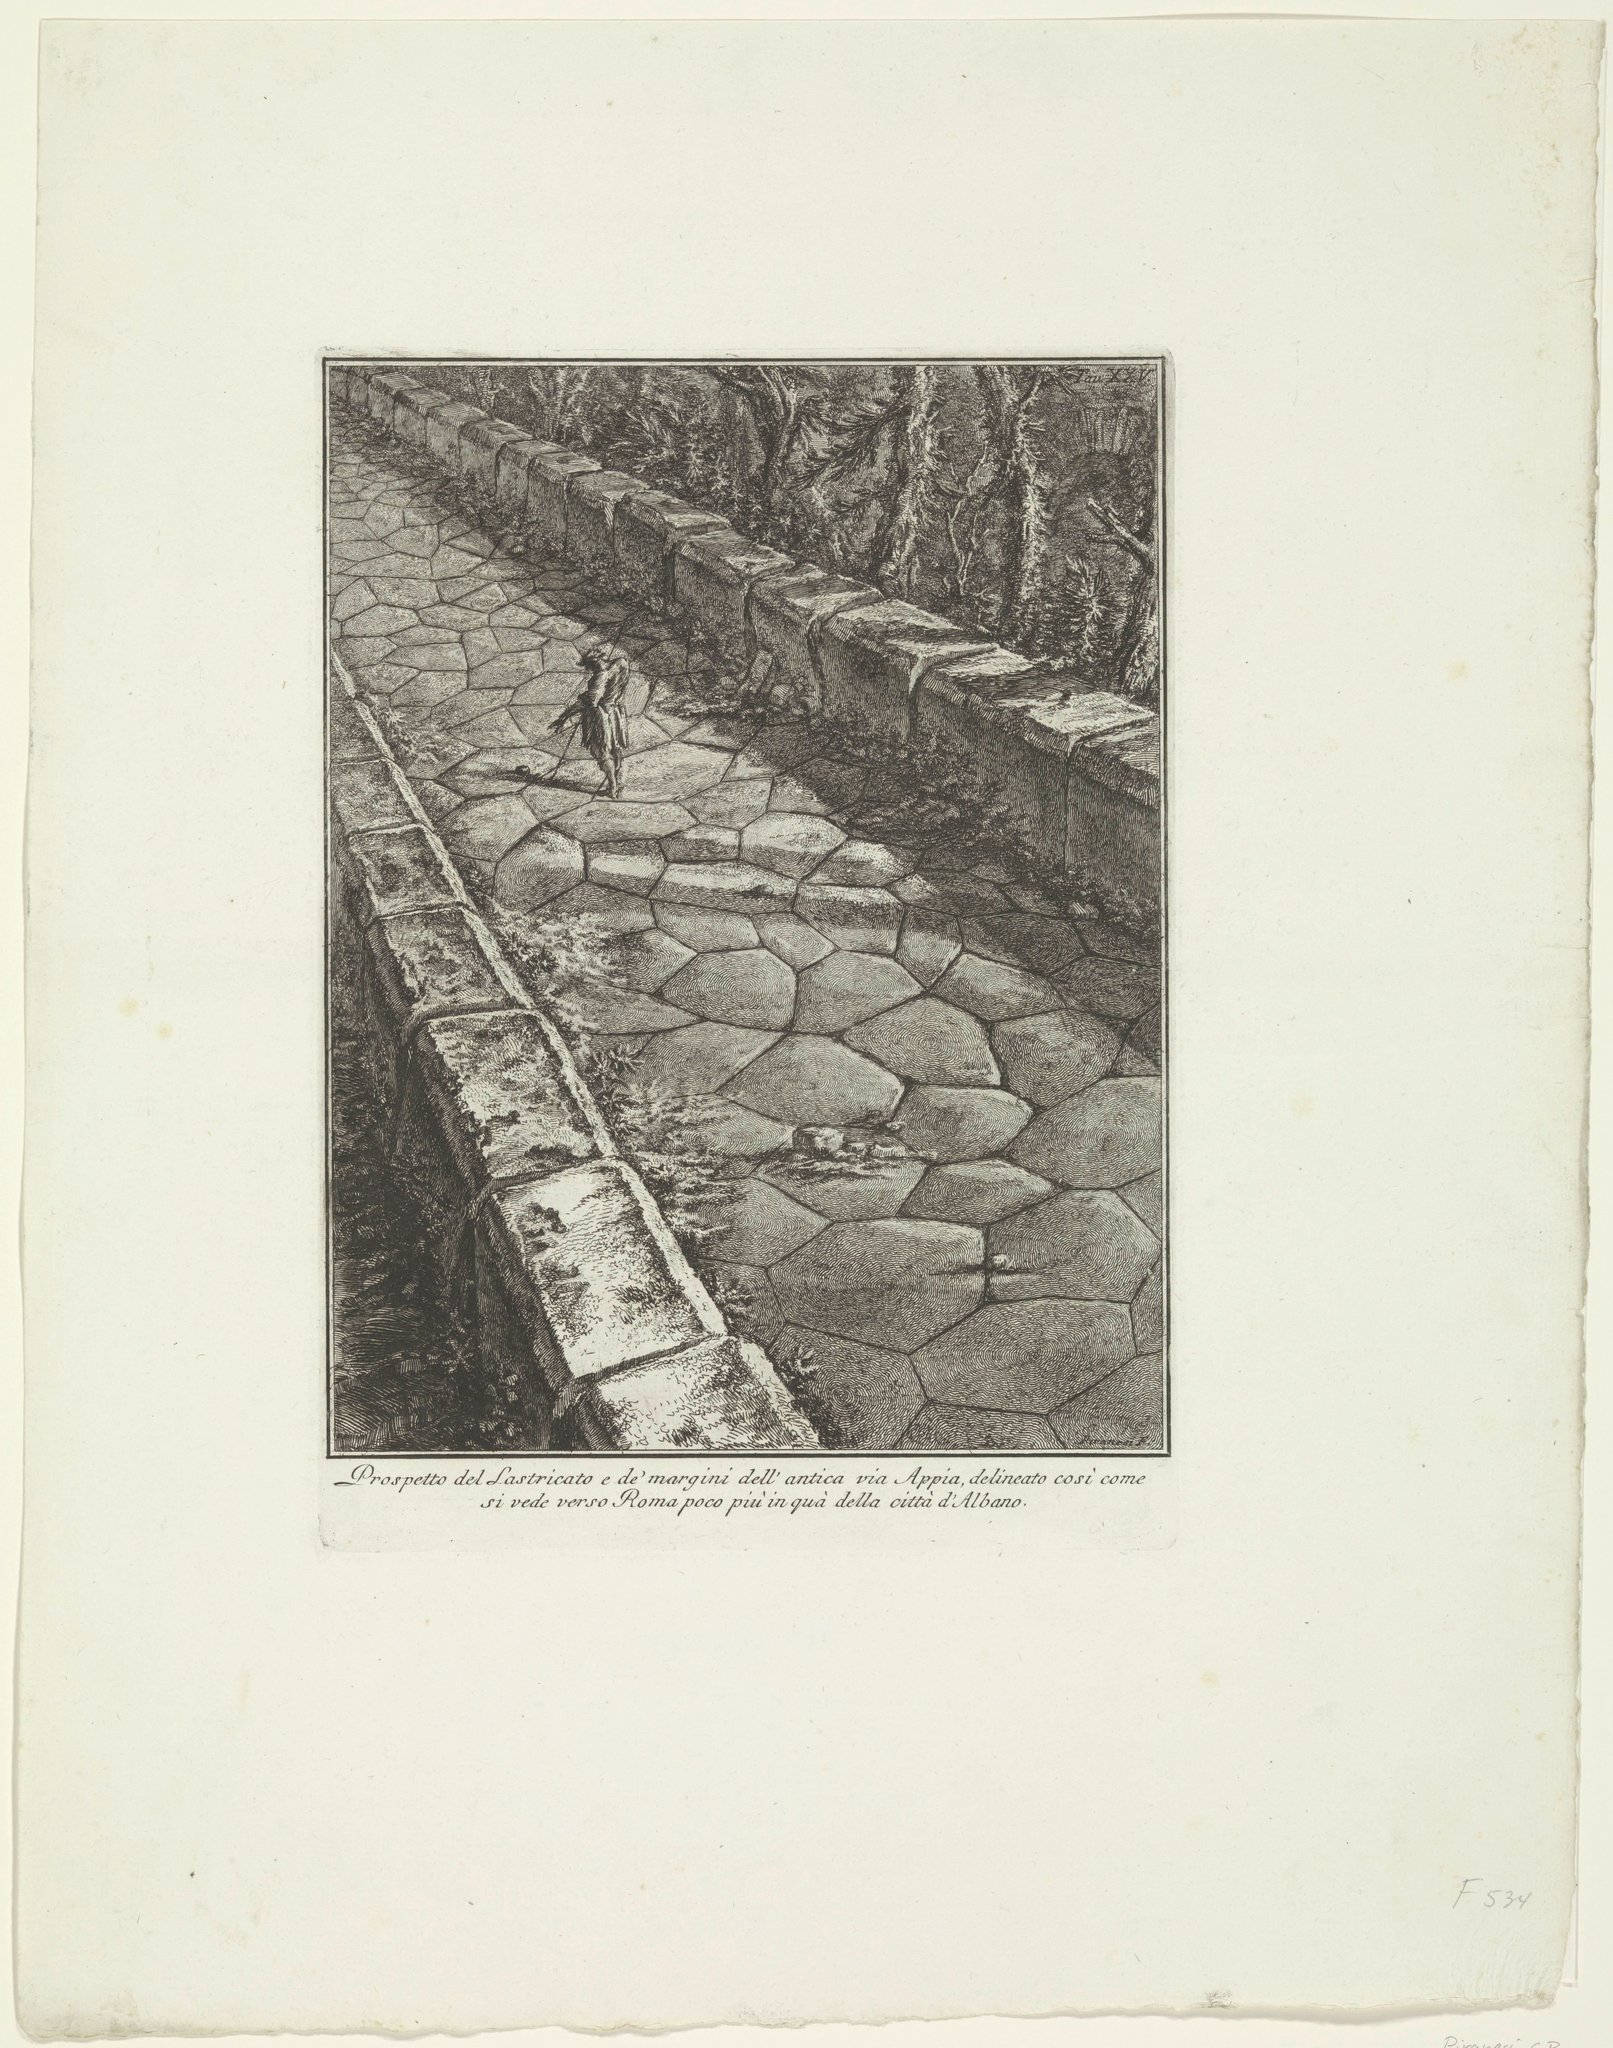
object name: print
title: Prospetto del Lastricato e de' margini dell'antica via Appi (...)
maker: giovanni battista piranesi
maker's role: designer, draughtsman, print maker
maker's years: 1720-1778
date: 1762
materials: paper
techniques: etching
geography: rome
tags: ruin of a building ~ architecture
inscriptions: collector's mark: Lugt 2228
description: Deze prent maakt deel uit van de serie van 33 prenten (inclusief titelprent, opdracht, vignet en ornamentele letter) met de titel 'Antichità d'Albano e di Castel Gandolfo'.